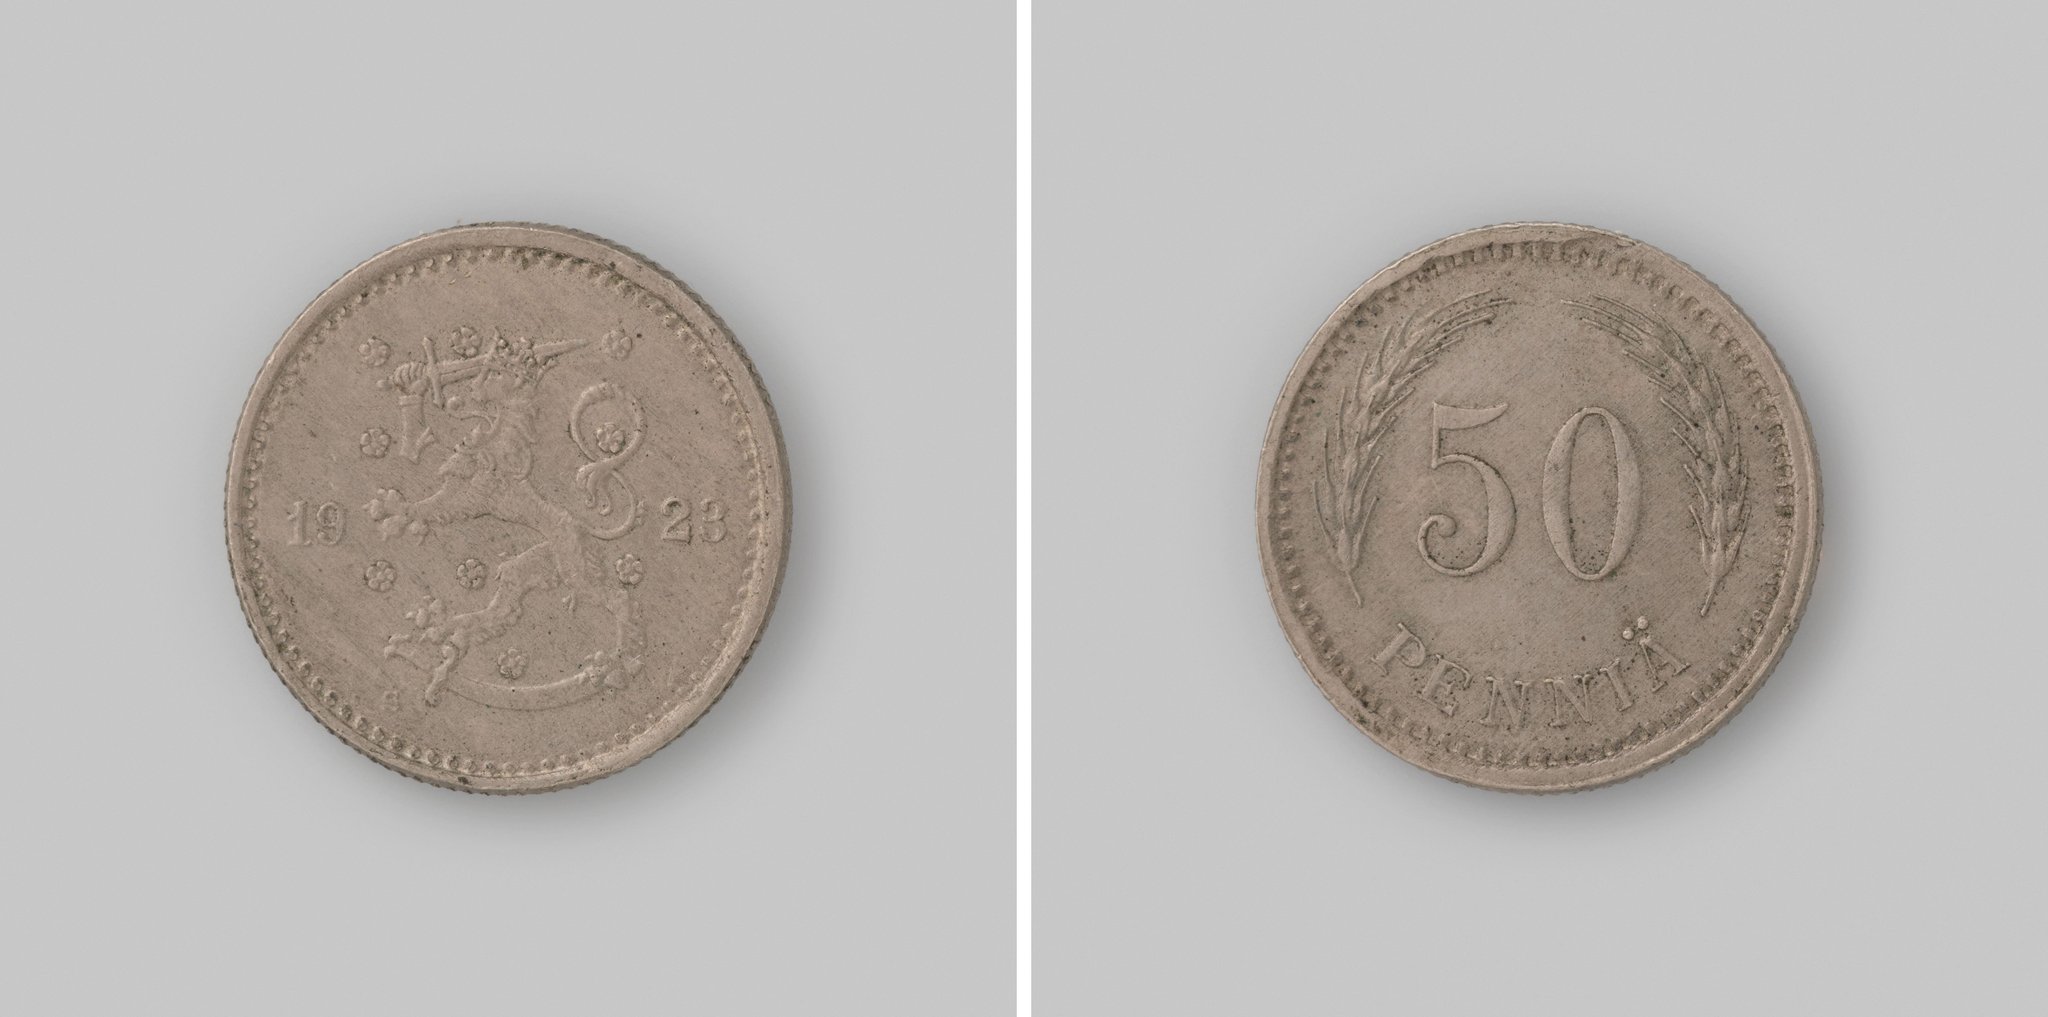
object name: coin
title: Finland, 50 penniä, 1923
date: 1923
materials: nickel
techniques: striking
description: Koper-nikkelen munt. Voorzijde: tussen jaartal wapen van Finland. Keerzijde: tussen twee takken waarde-aanduiding in twee regels. Kartelrand.